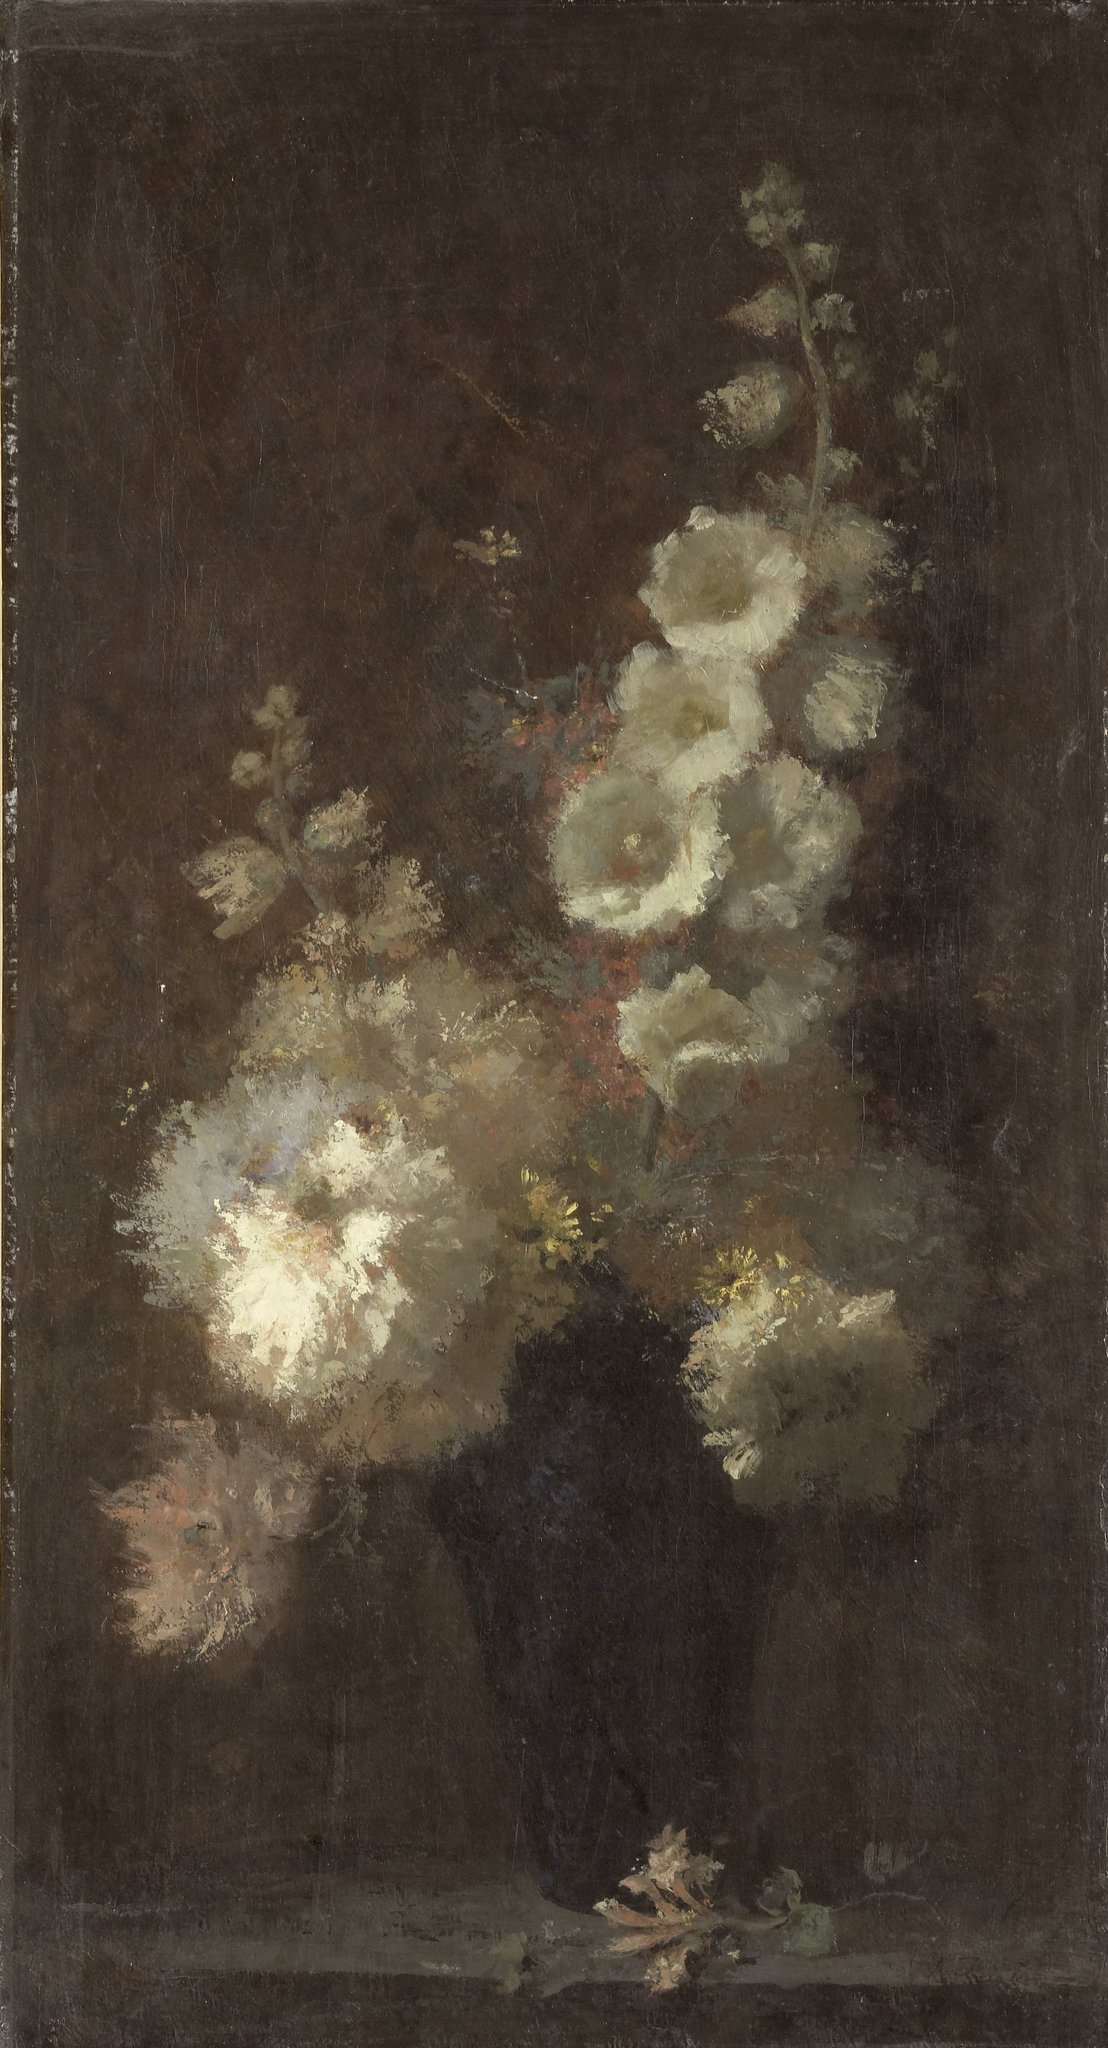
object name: painting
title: Still Life wit Flowers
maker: auguste jouve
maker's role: painter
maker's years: 1846-1887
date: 1870-1877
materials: canvas, oil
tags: cut flowers; nosegay, bunch of flowers, flowers: hollyhock, flowers in a vase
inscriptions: signature: ‘A. Jouve’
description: Stilleven met bloemen. Boeket met stokrozen in een pot staande op een tafel.